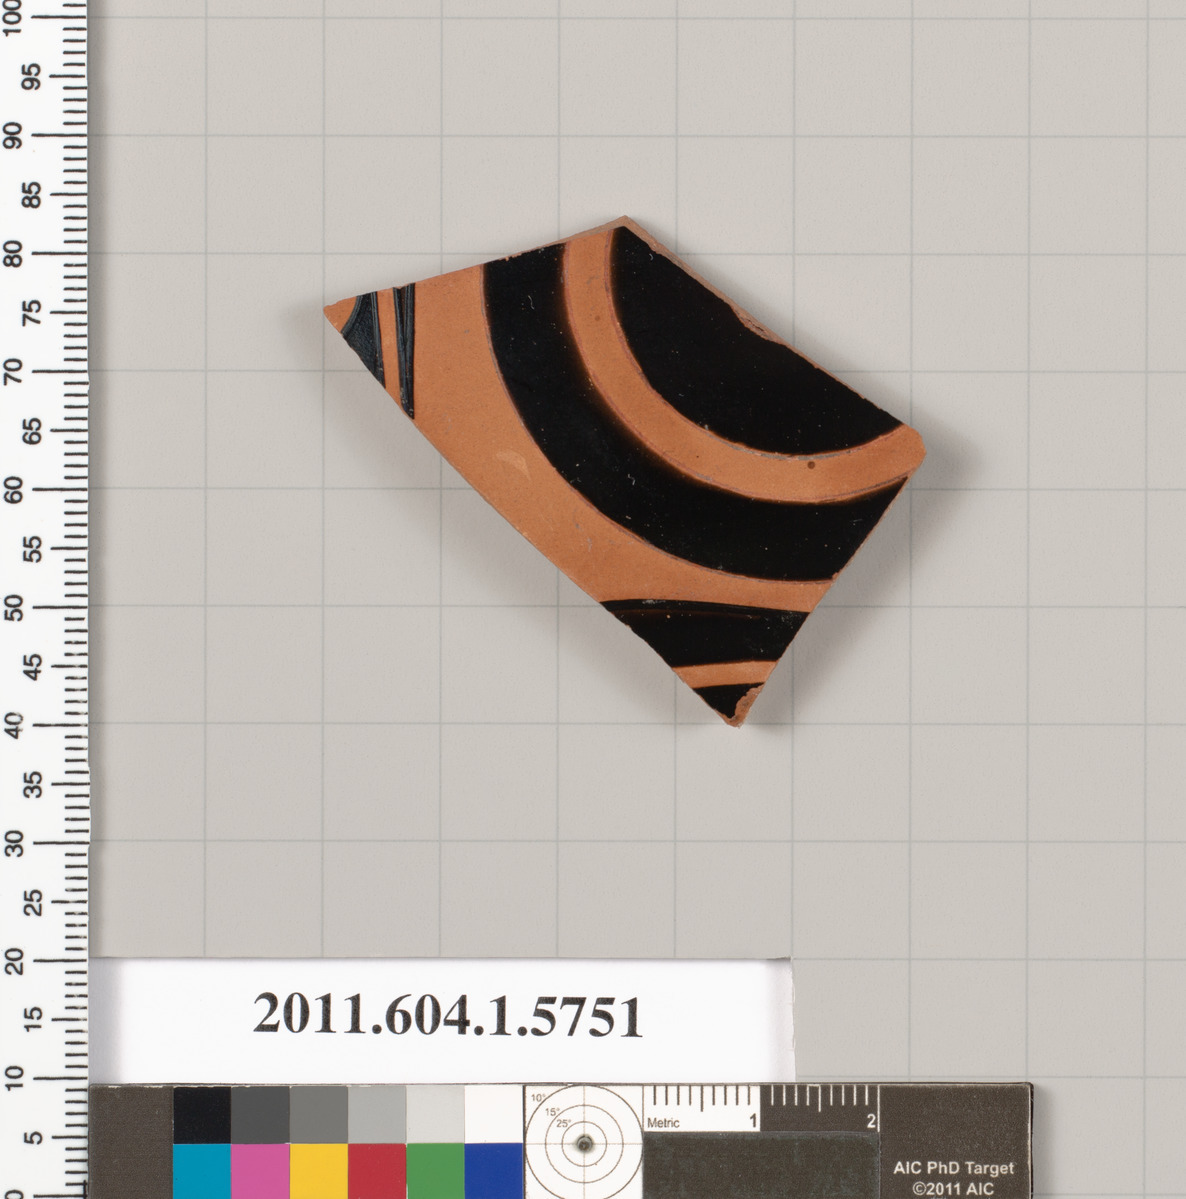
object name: kylix fragment, eye cup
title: Terracotta rim fragment of a kylix: eye-cup (drinking cup)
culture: greek, attic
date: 525-515 BCE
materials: terracotta